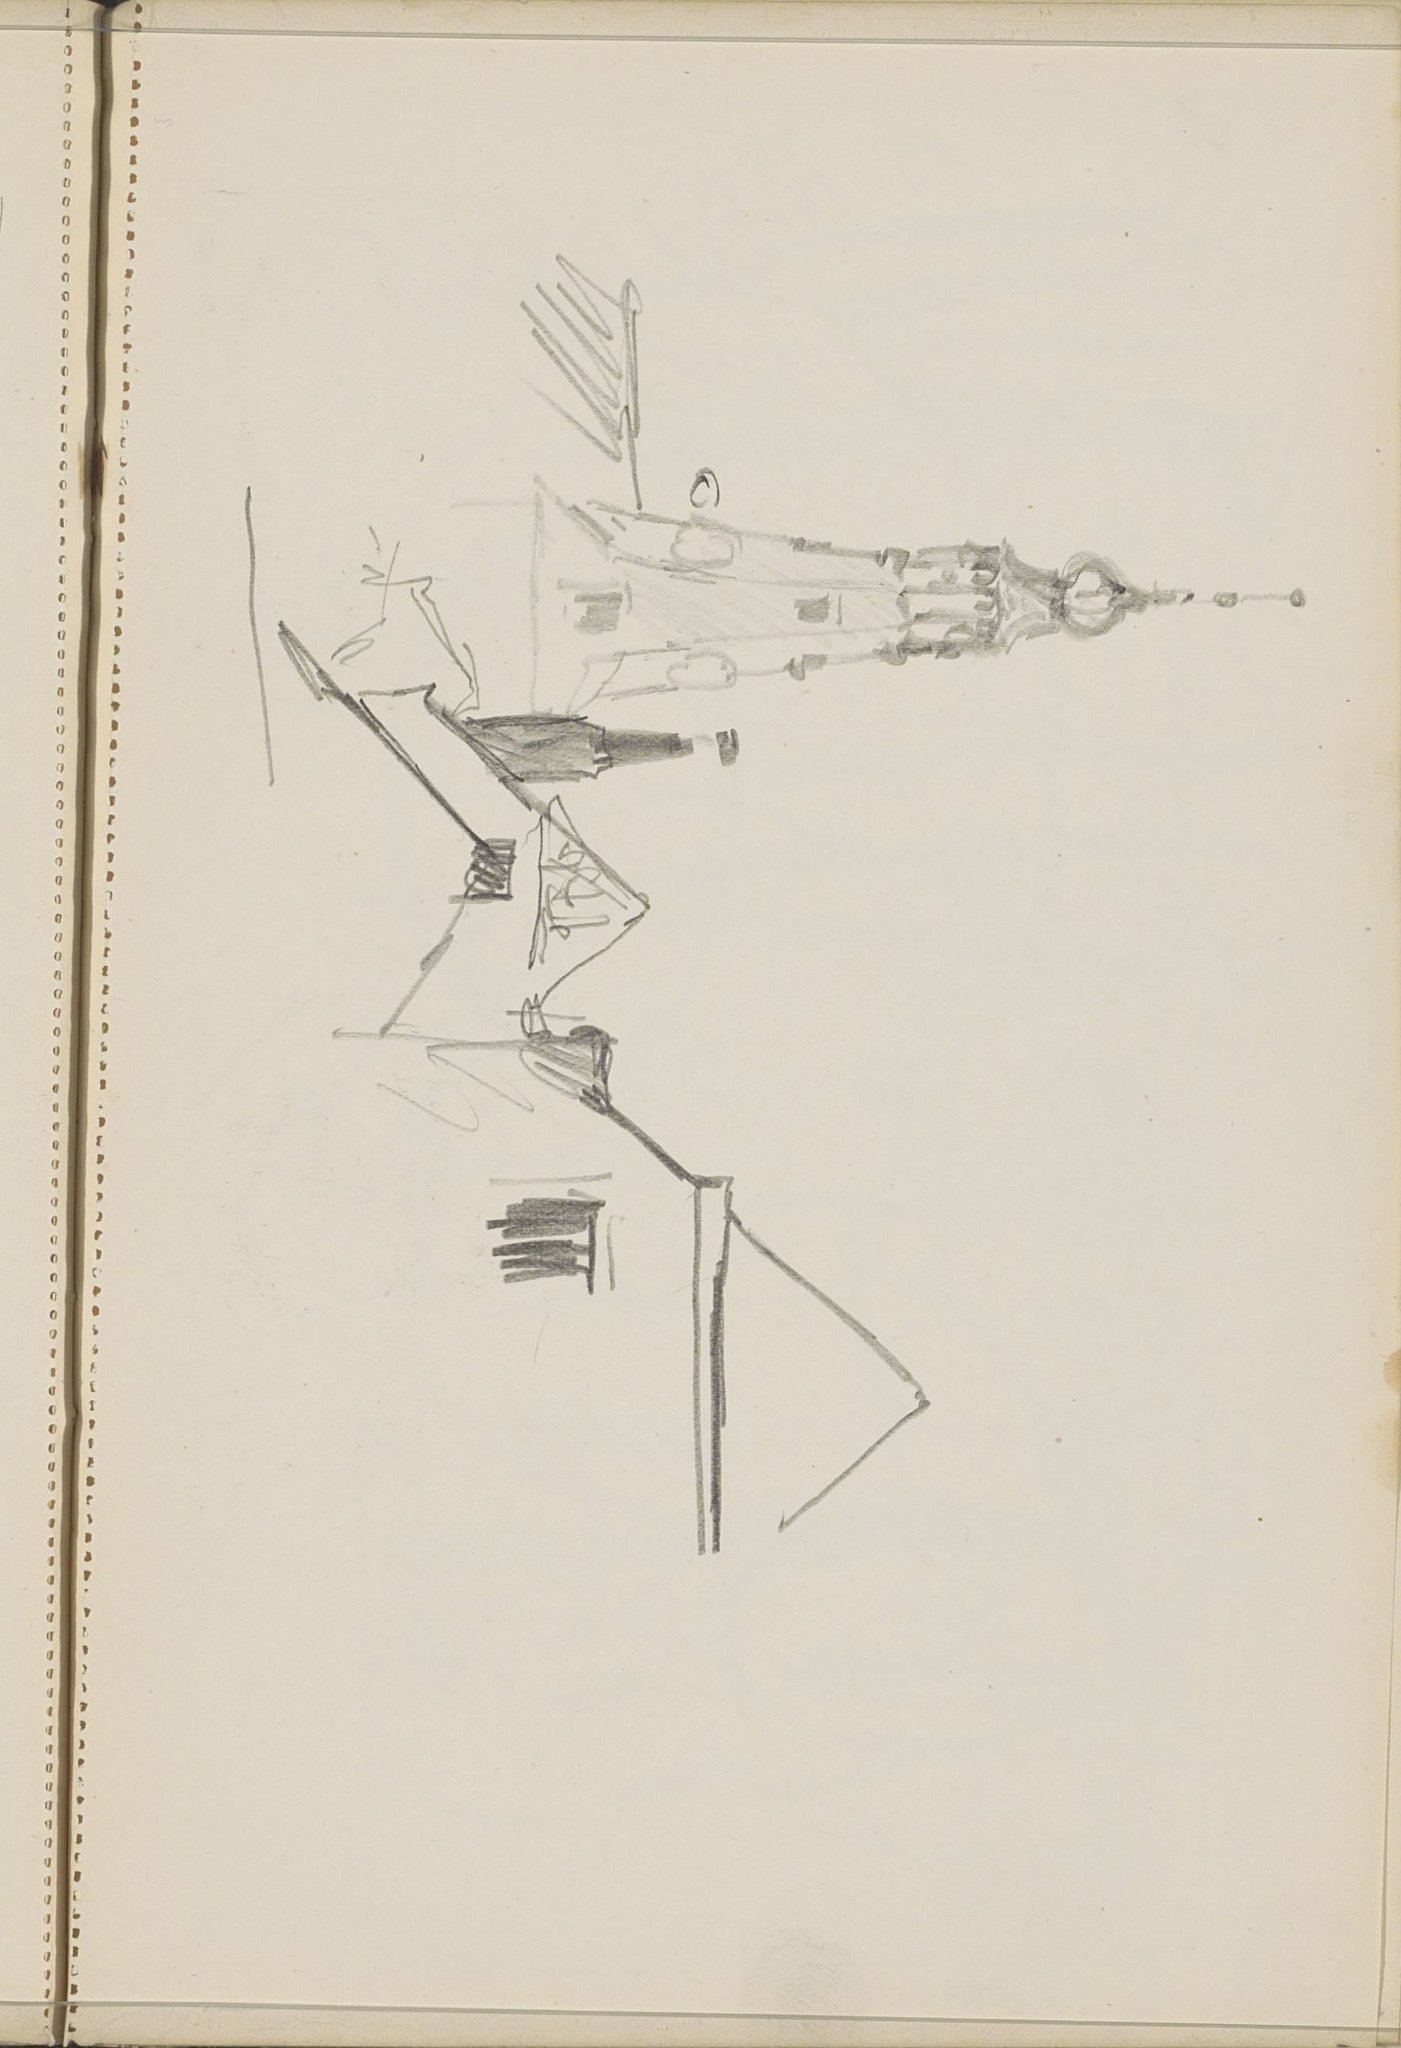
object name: sketchbook leaf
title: Kerktoren tussen een rij huizen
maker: cornelis vreedenburgh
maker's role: draughtsman, print maker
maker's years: 1880-1946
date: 1890-1946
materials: paper, pencil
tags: parts of church exterior and annexes: tower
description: Blad 45 recto uit een schetsboek met 59 bladen.